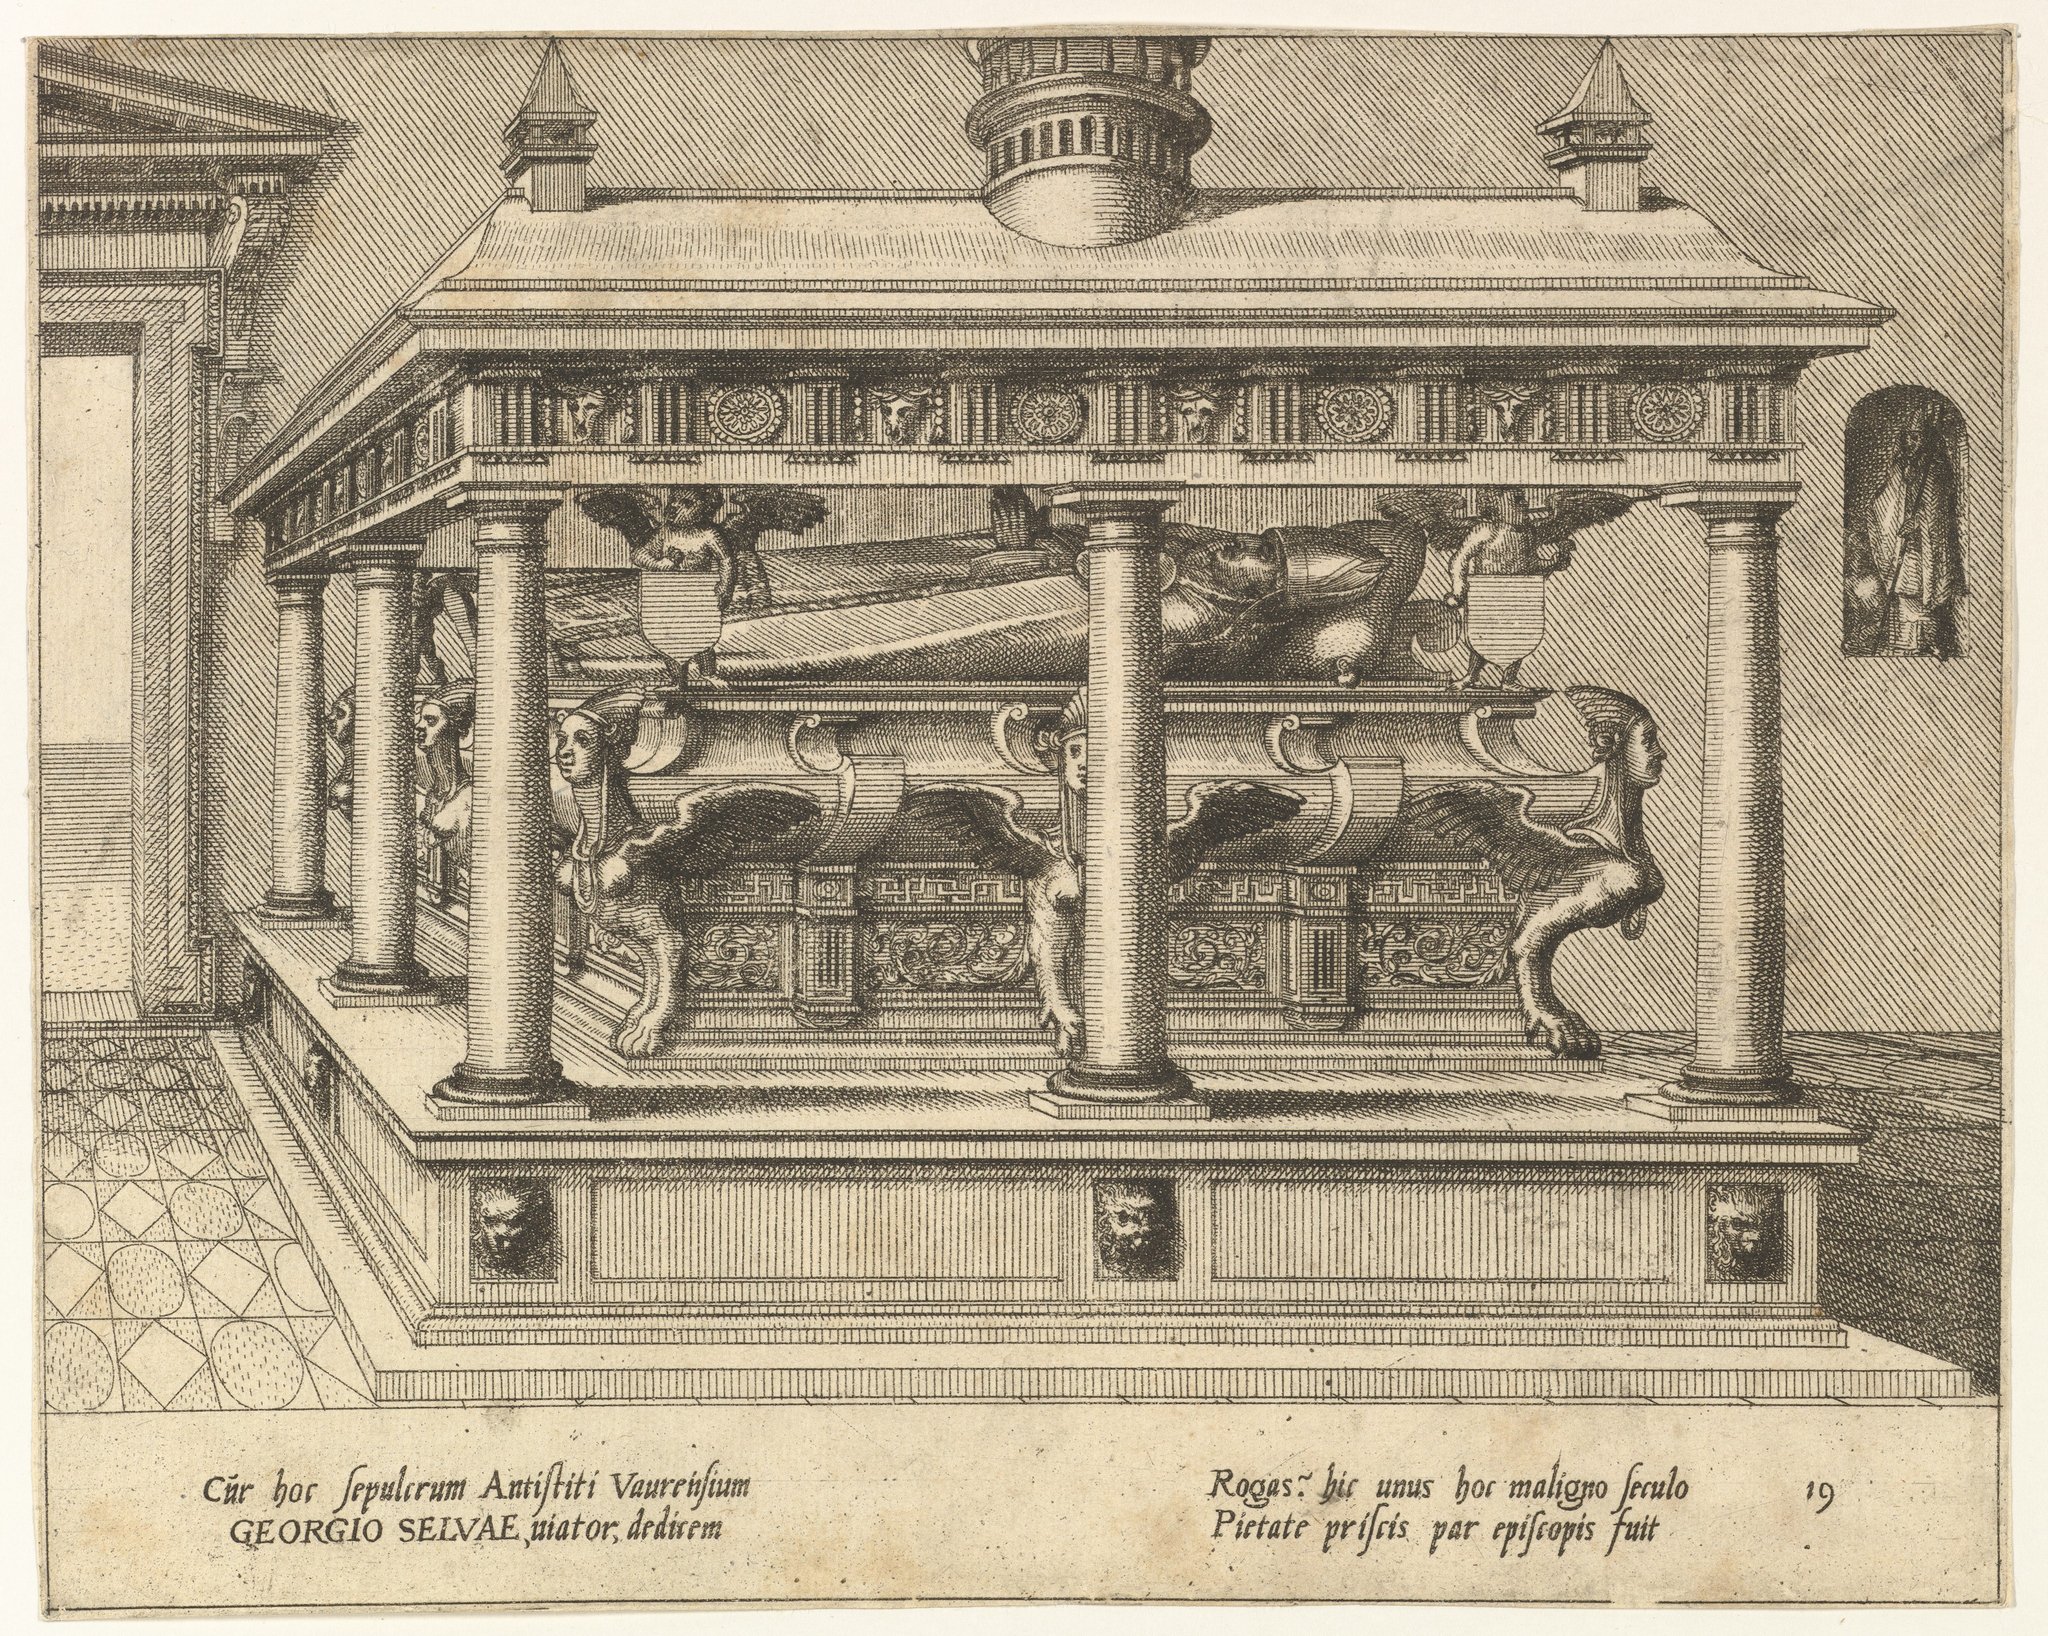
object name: collection ornament architecture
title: Cœnotaphiorum (19)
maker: hans vredeman de vries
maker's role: artist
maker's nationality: netherlandish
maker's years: 1527-1606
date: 1563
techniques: etching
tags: tombs,men,bishops